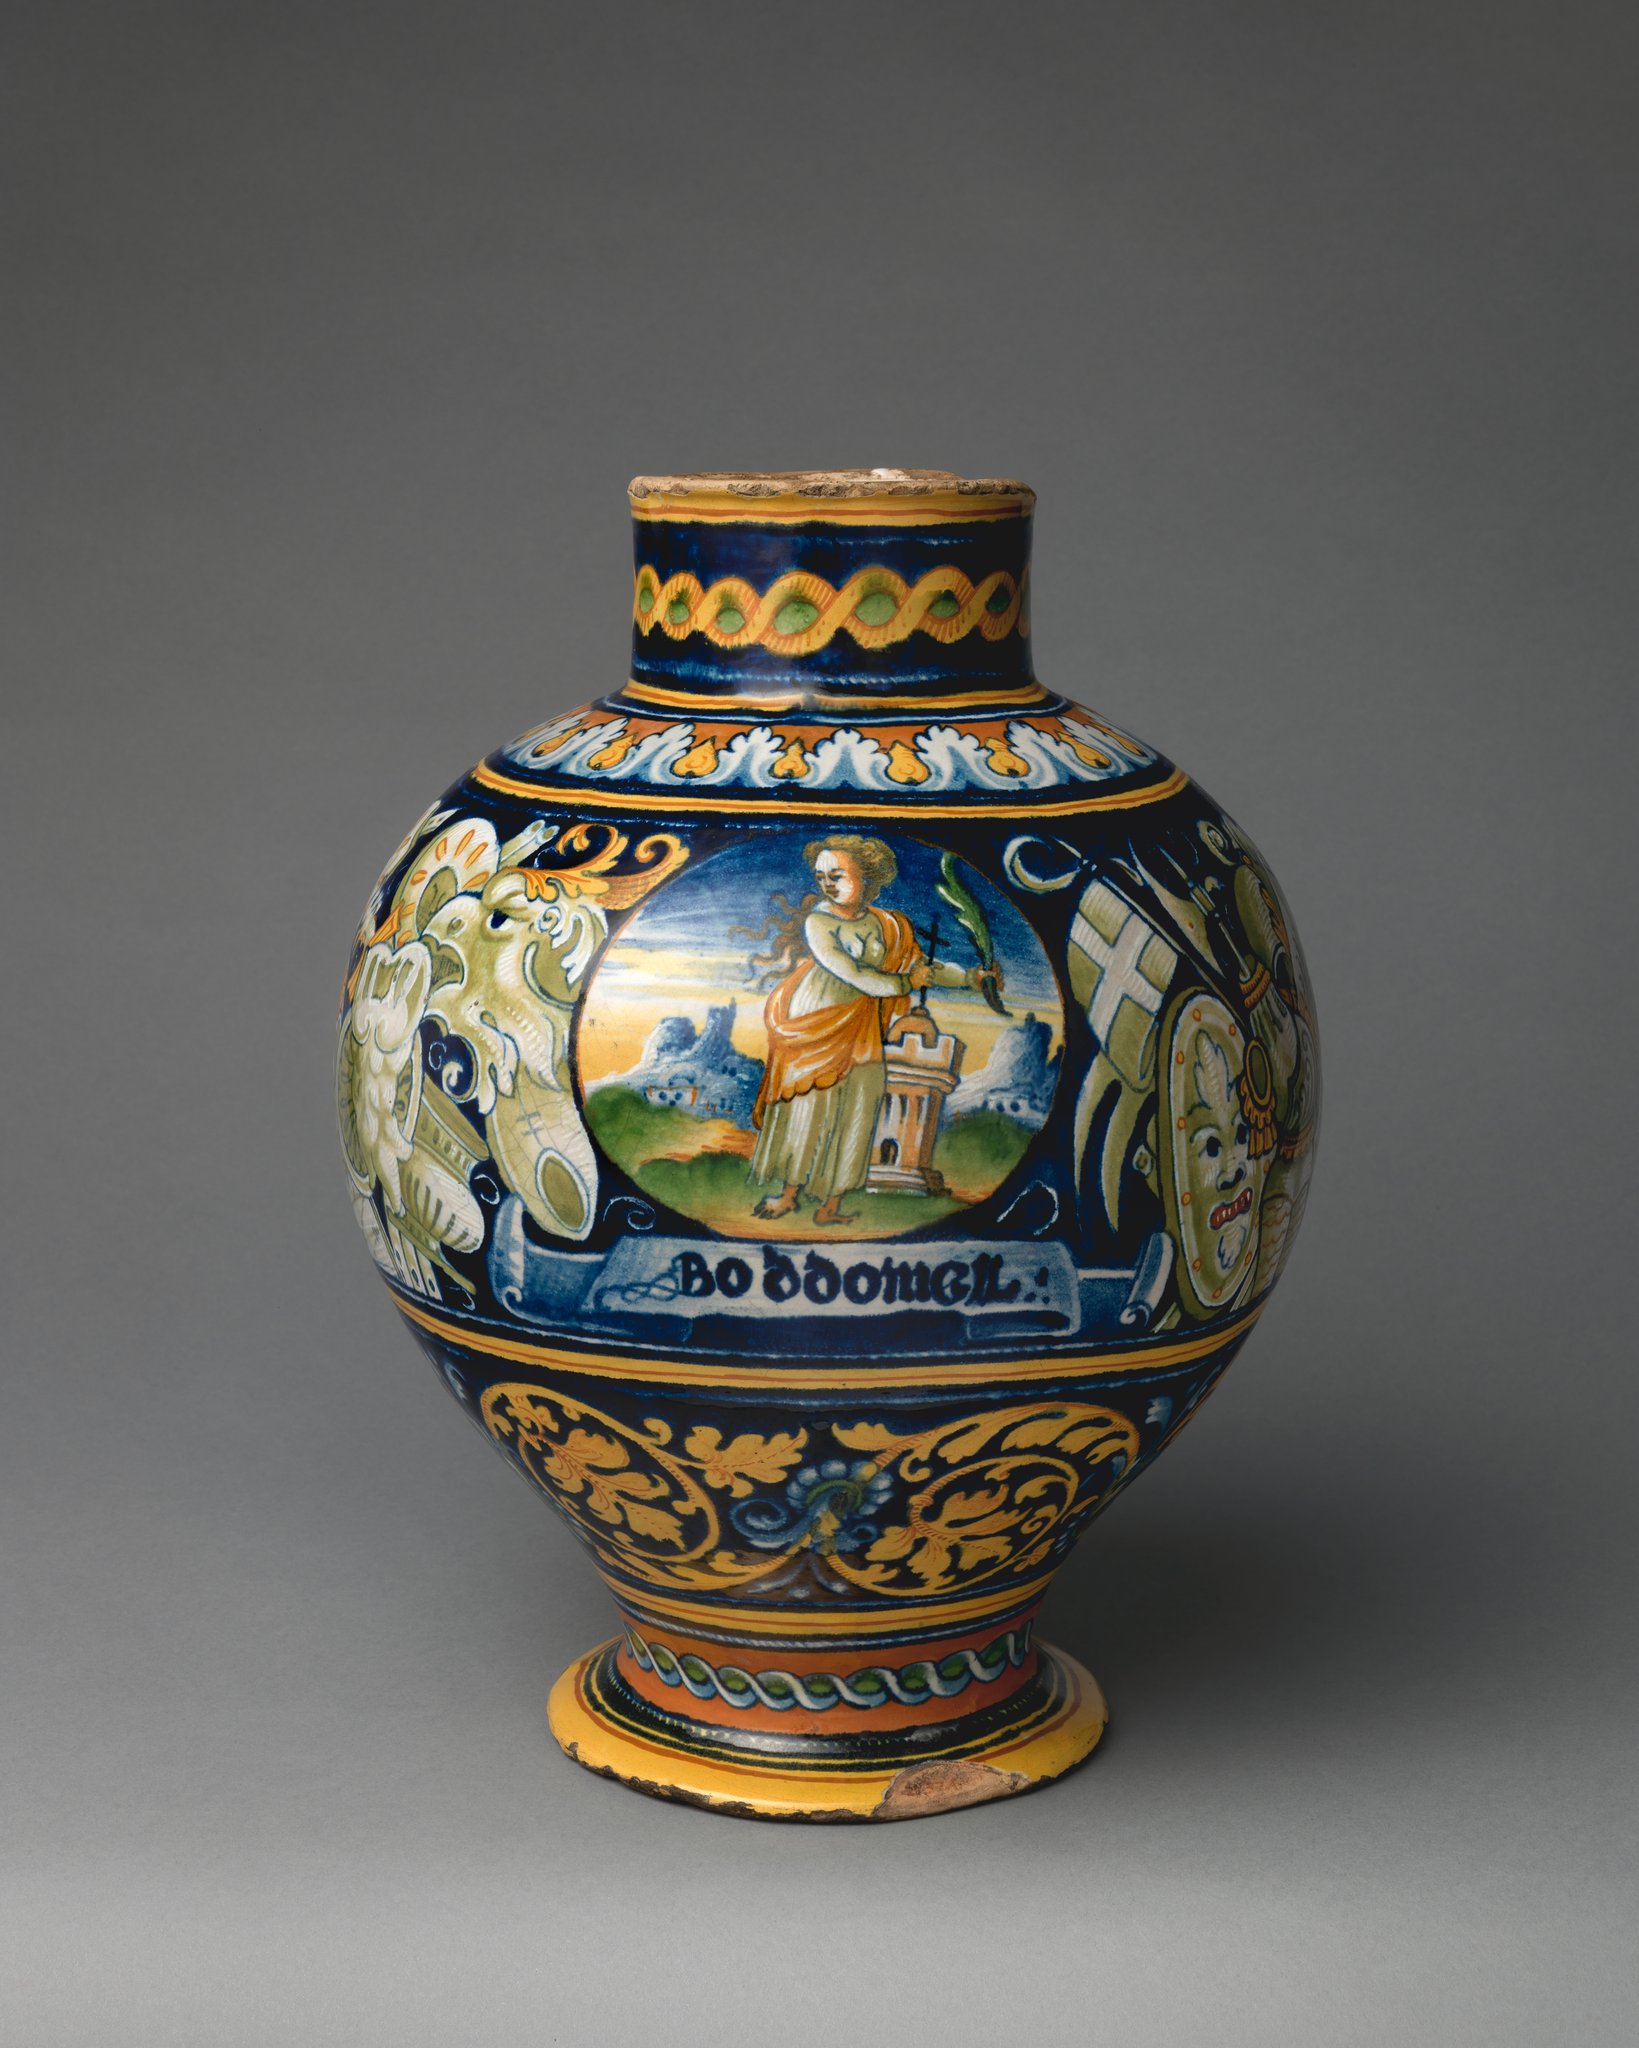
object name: vase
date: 1801-1900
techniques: maiolica, glazing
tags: birds,women